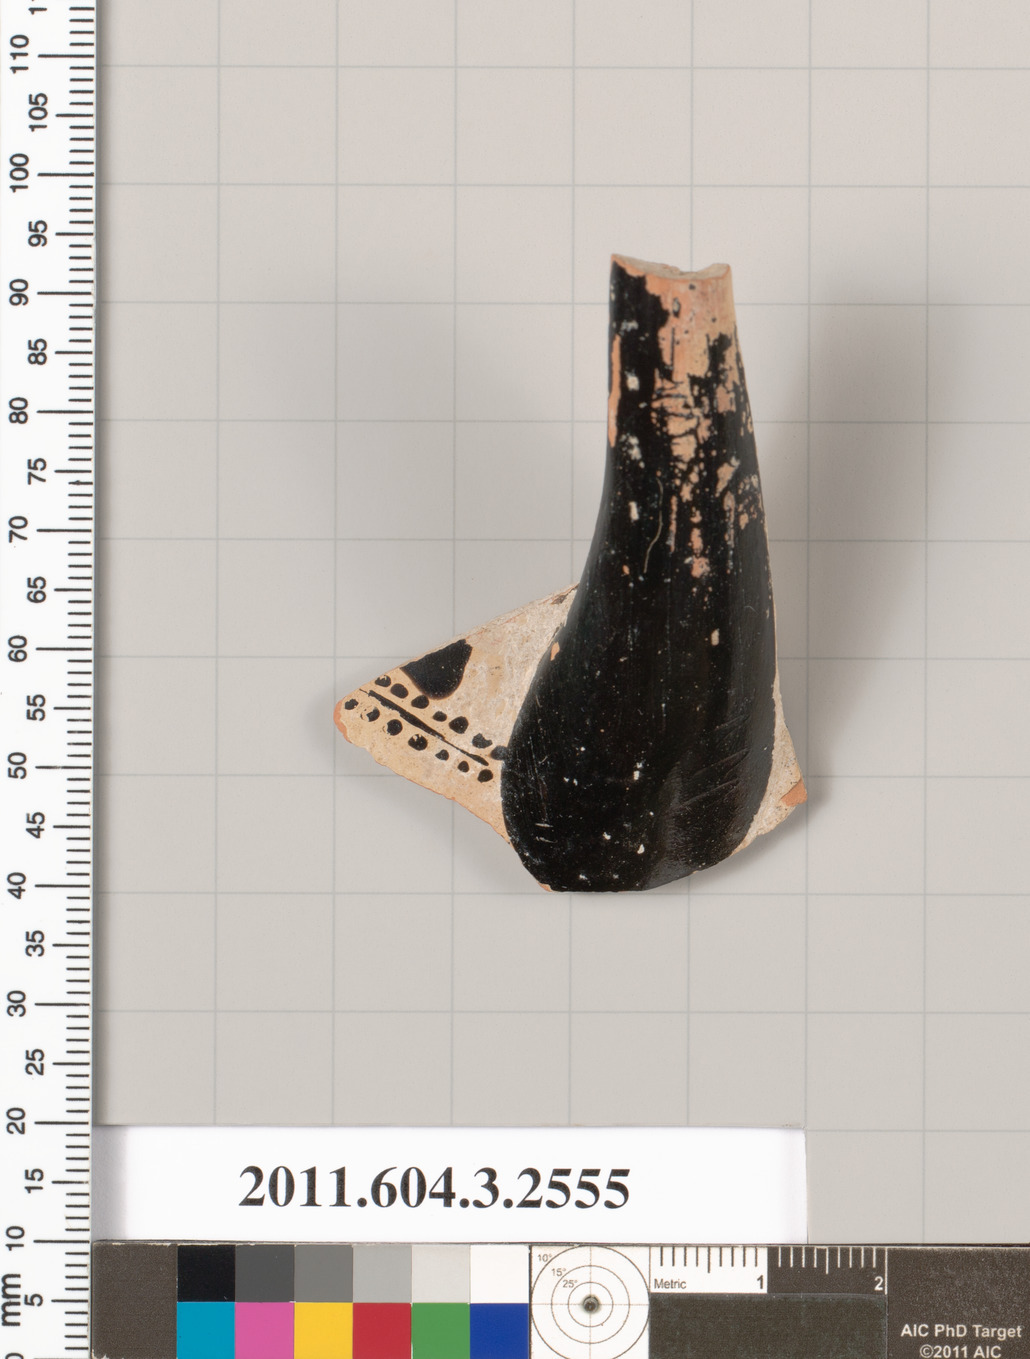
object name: kylix fragment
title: Terracotta fragment of a kylix (drinking cup)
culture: greek, attic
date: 534-468 BCE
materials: terracotta